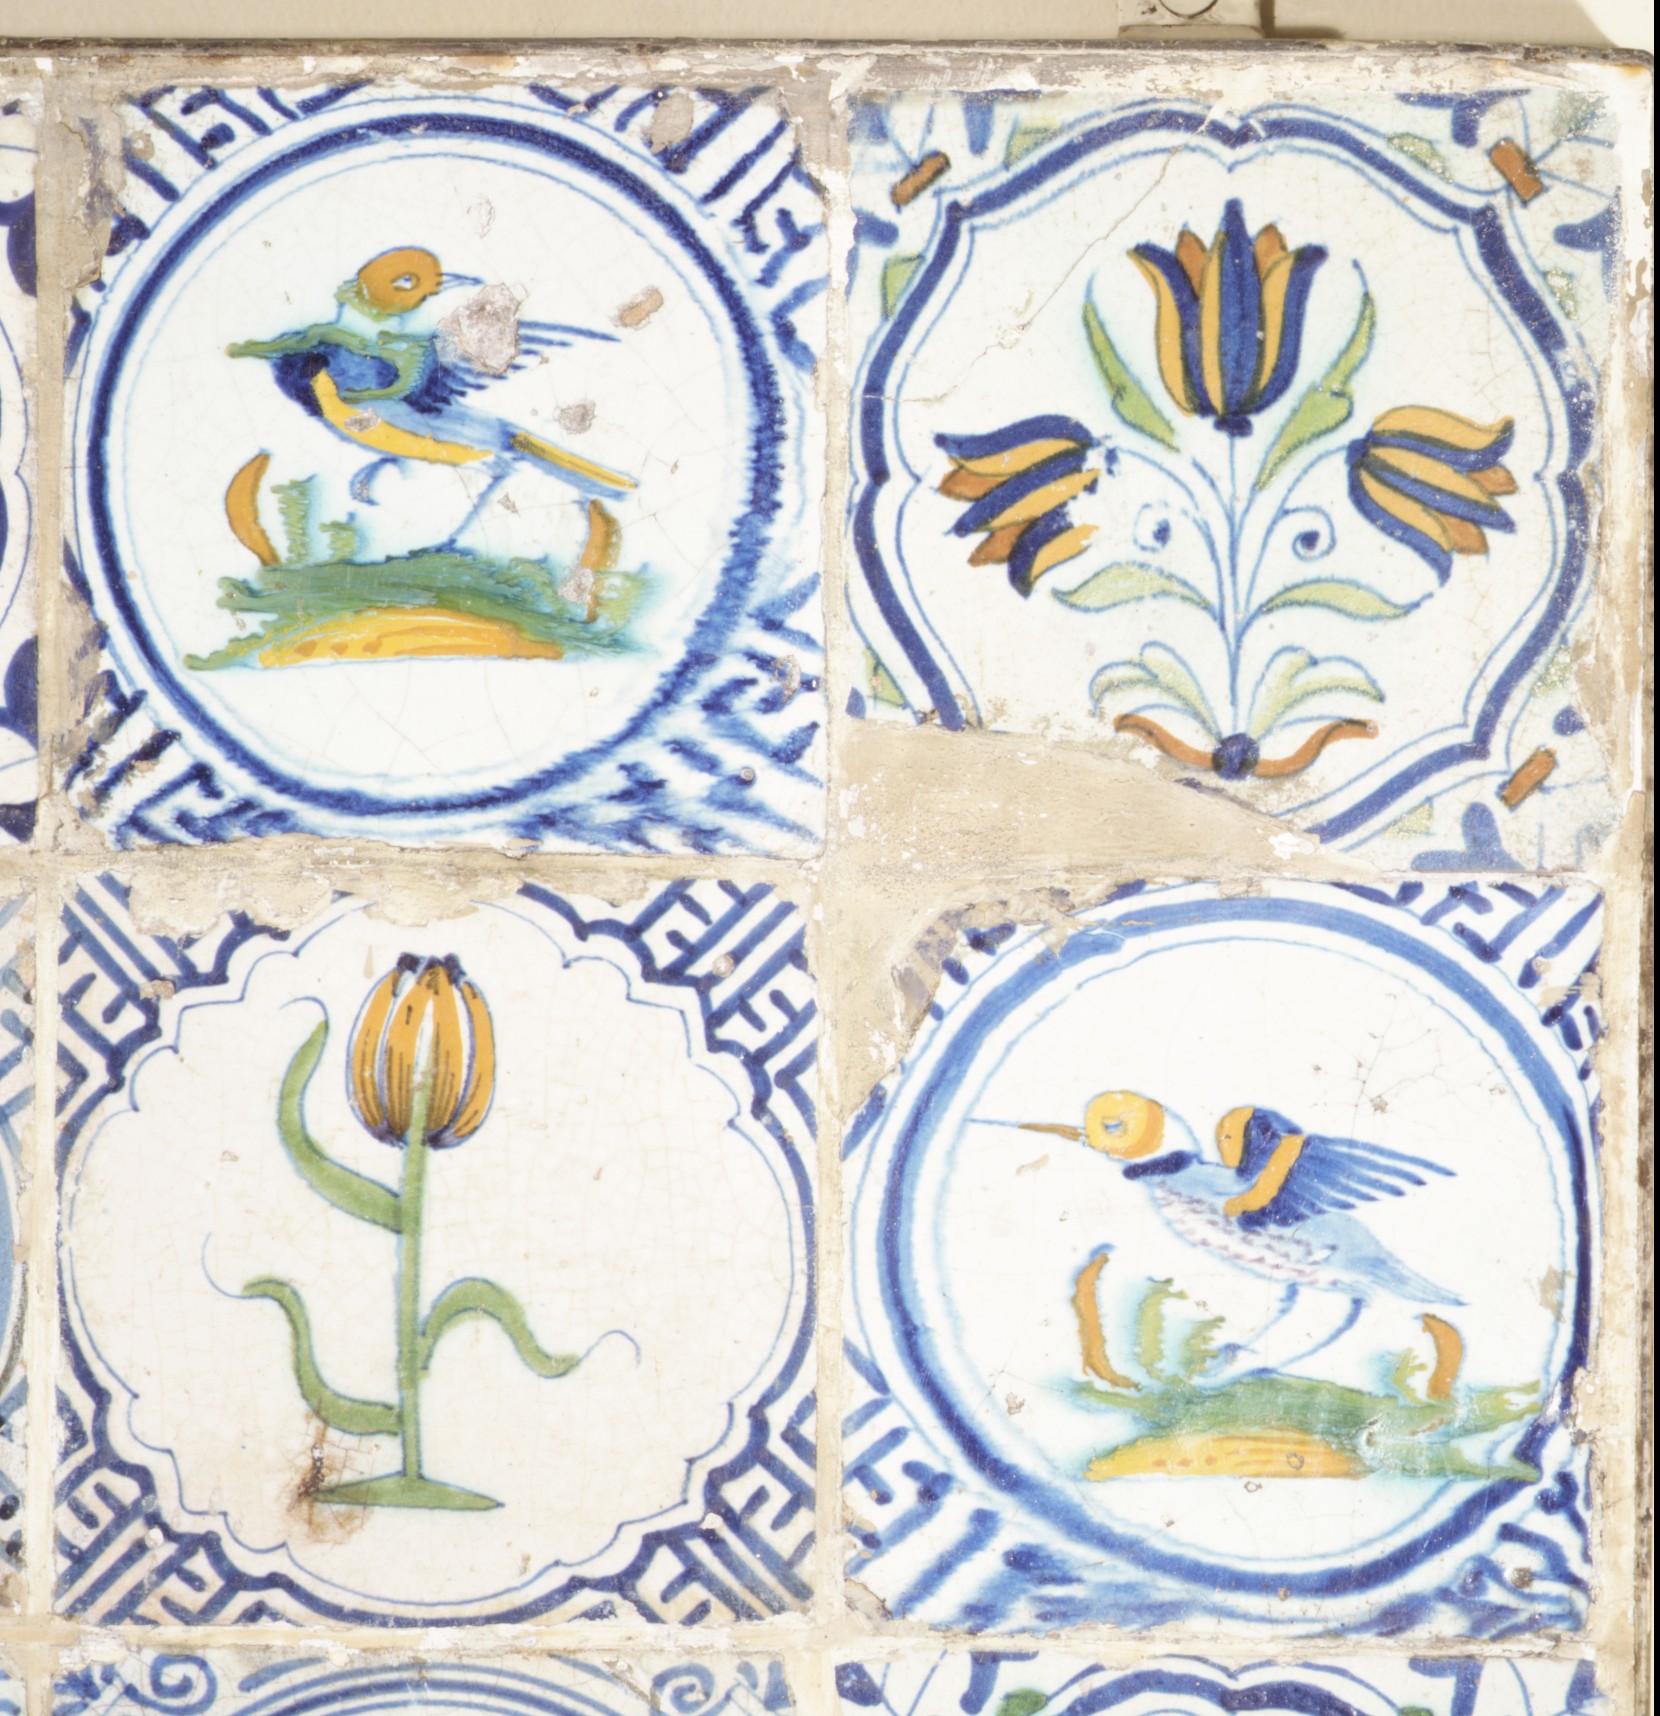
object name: tile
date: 1620-1640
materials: earthenware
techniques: glazing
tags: birds,flowers